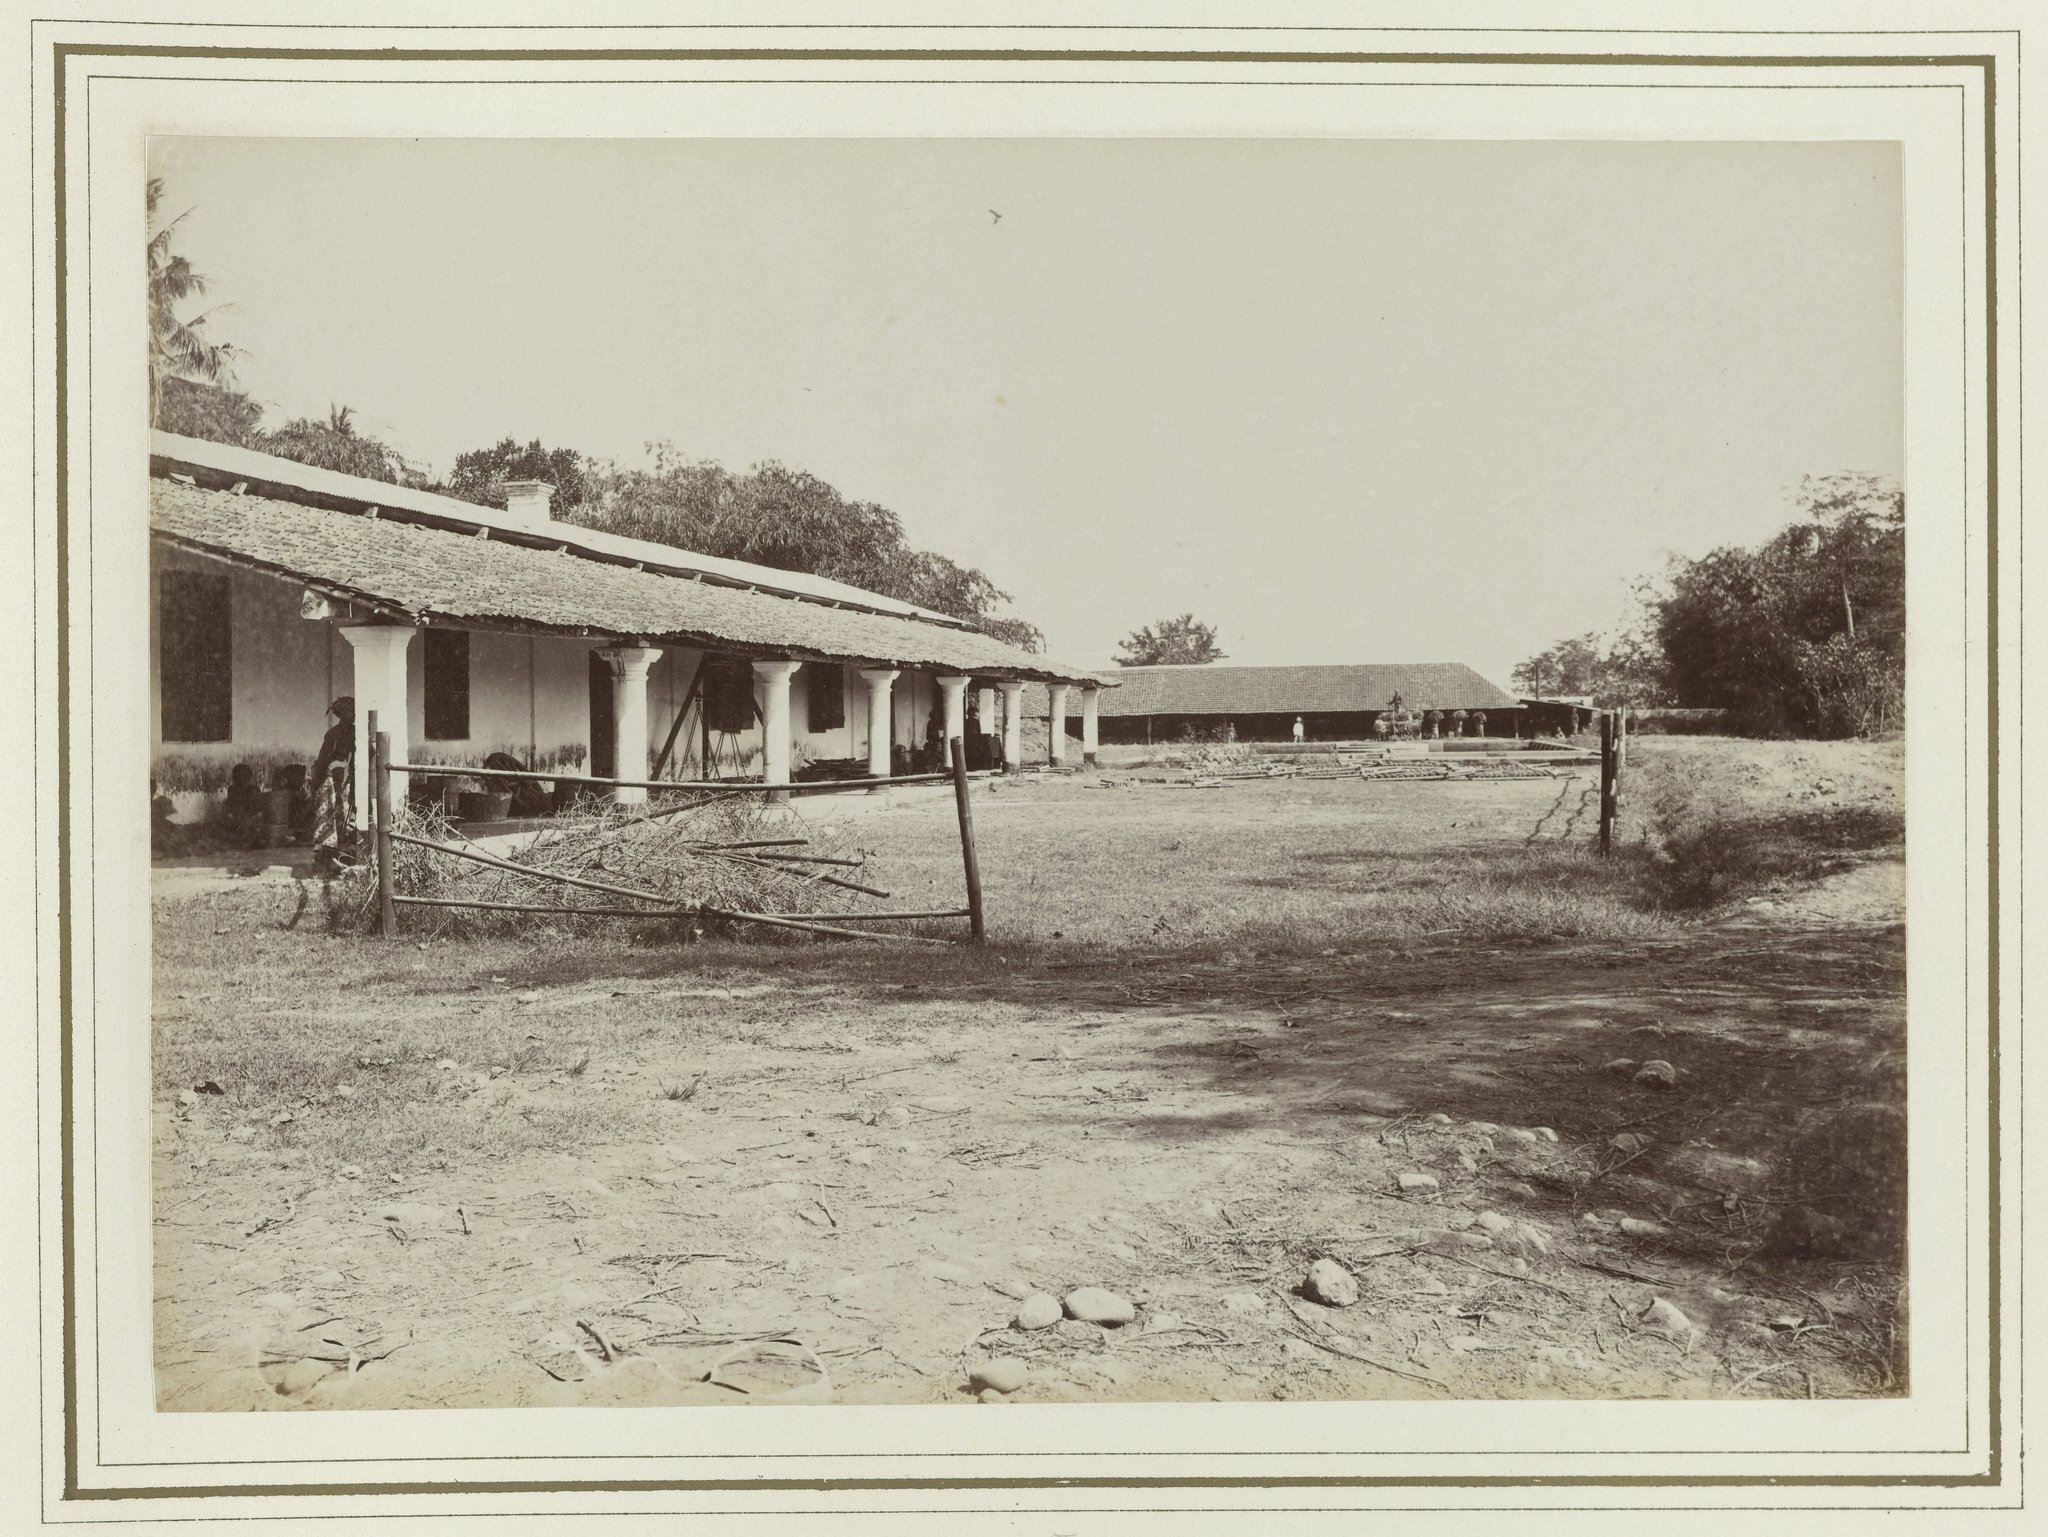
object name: photograph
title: Bedrijfsgebouwen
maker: kassian céphas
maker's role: fotograaf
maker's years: 1845-1912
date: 1886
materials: photographic support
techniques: albumen print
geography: jogjakarta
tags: the hague, colonial system, plantation, factory-building, (non-fruit) products of plants or trees: indigofera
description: Bedrijfsgebouwen voor de productie van de kleurstof indigo. Mogelijk gaat het hier om het bedrijf Pendoelan, waar Pijnacker Hordijk eigenaar van was. Onderdeel van het fotoalbum aangeboden aan J.M. Pijnacker Hordijk bij zijn vertrek uit Jogyakarta in 1886.